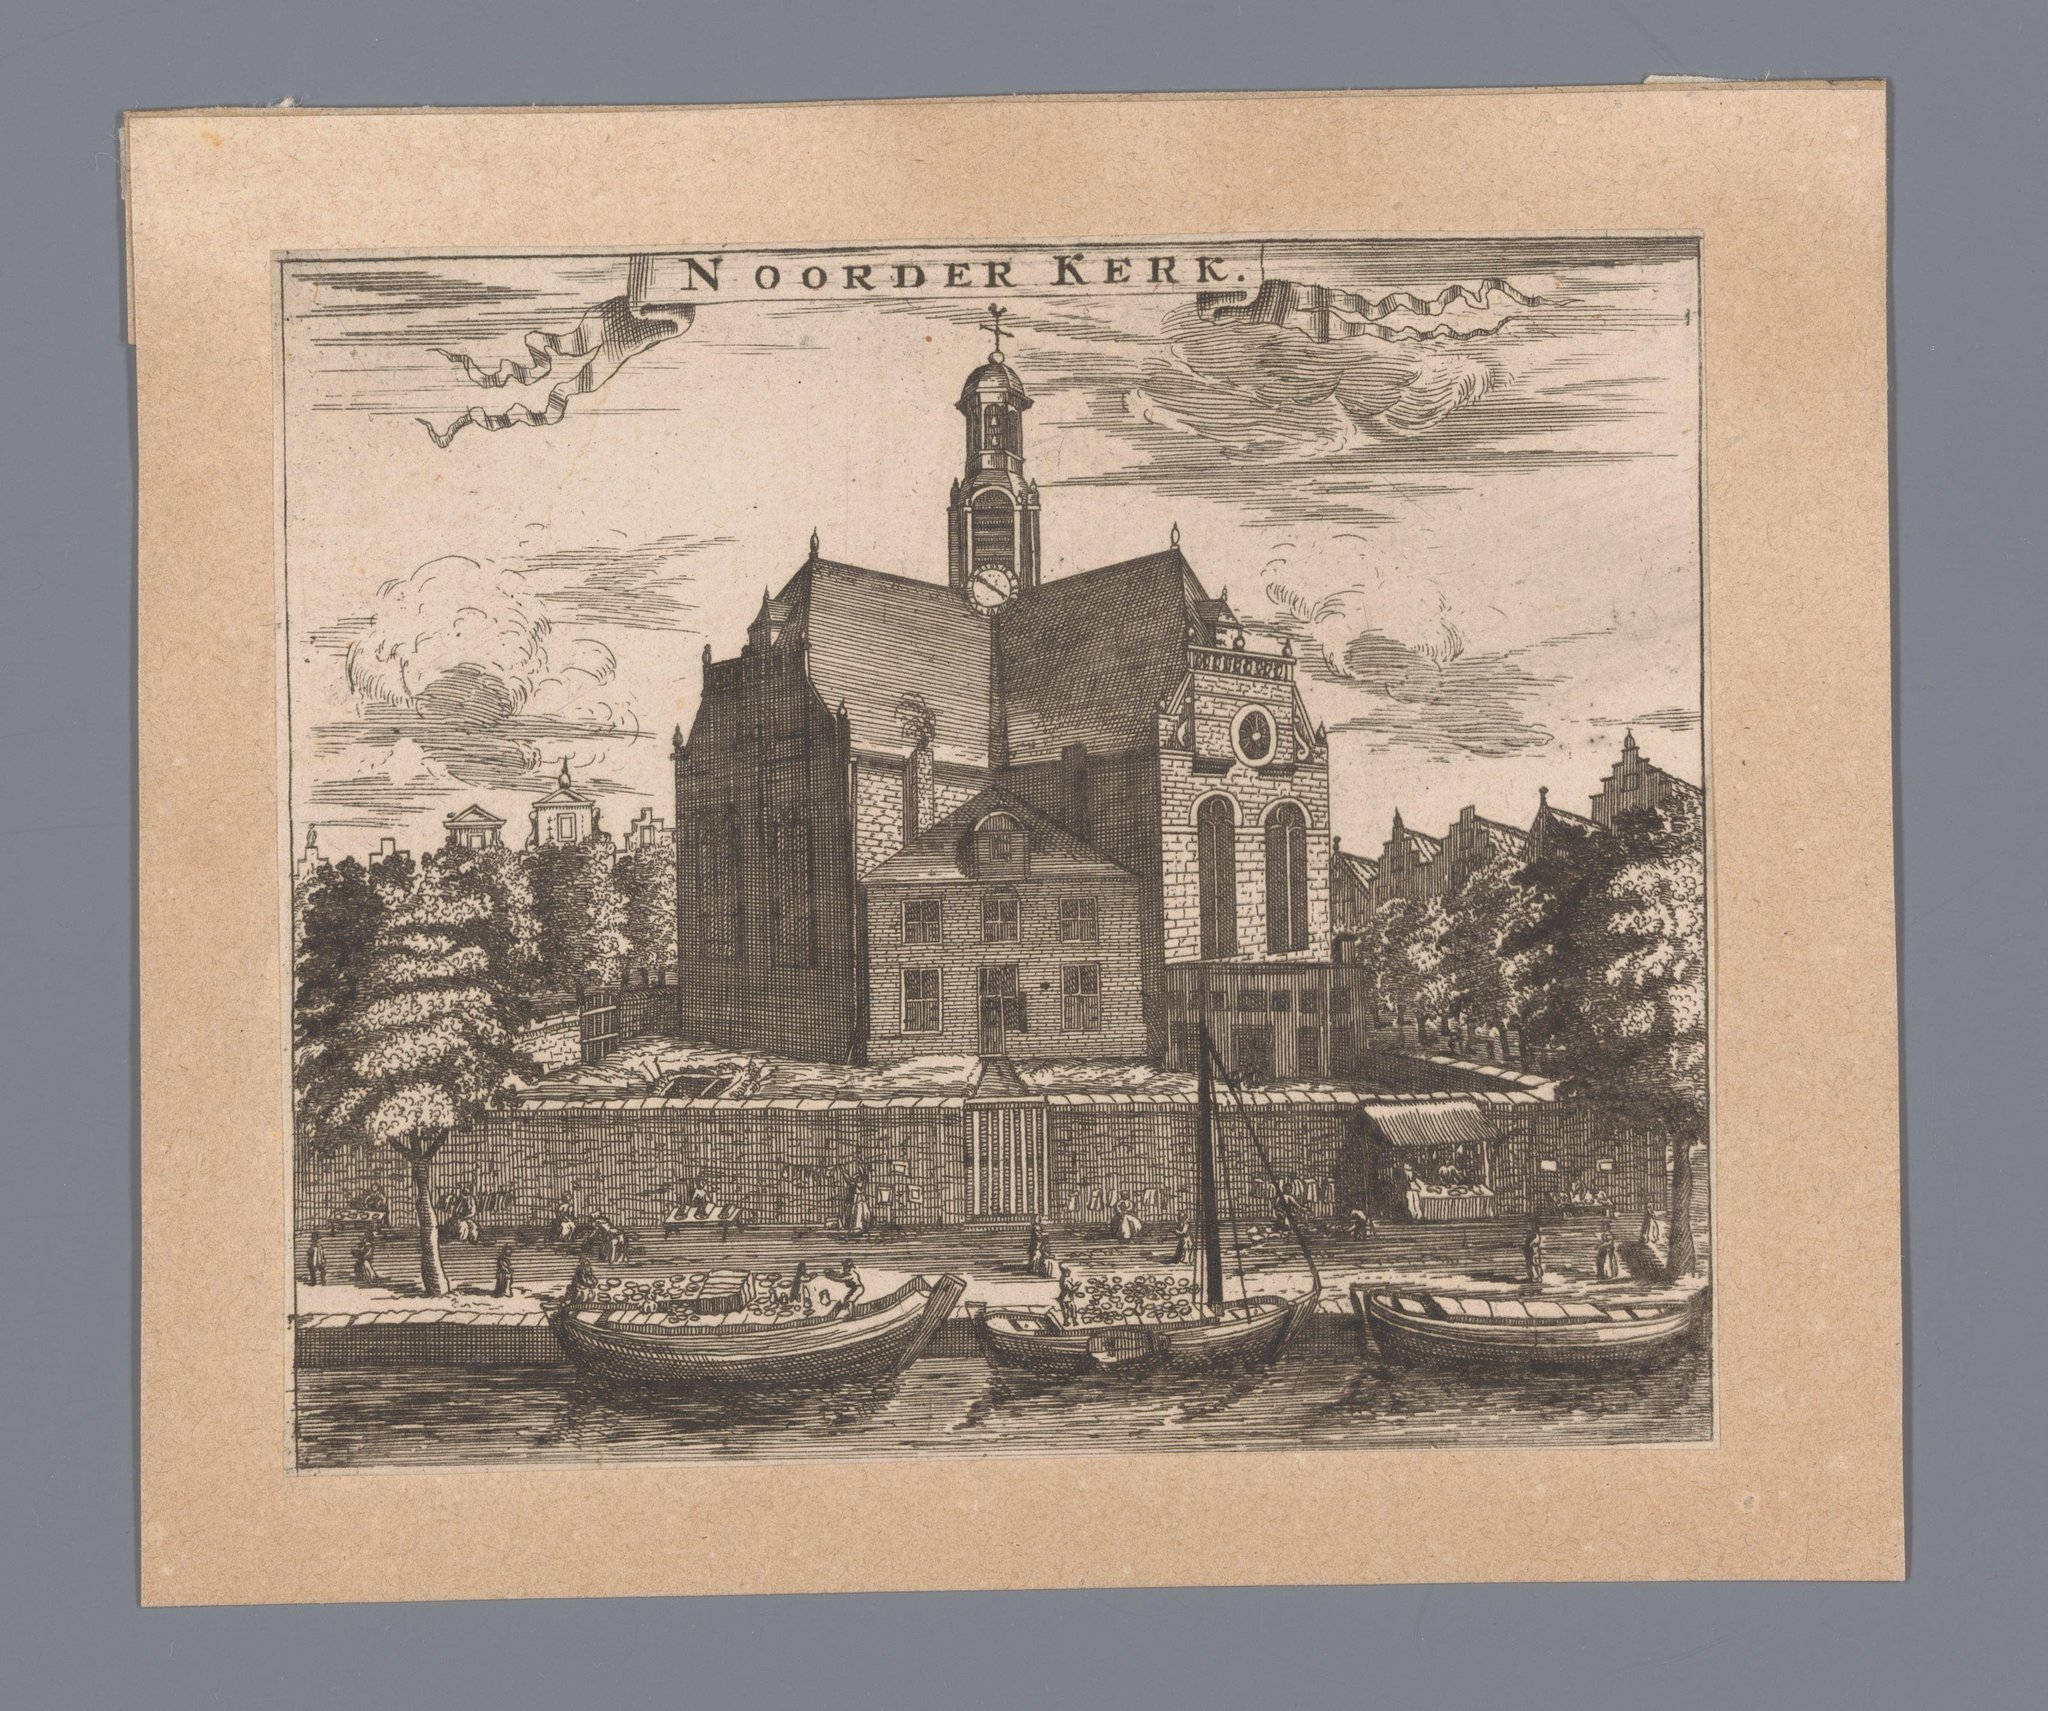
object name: print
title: Gezicht op de Noorderkerk te Amsterdam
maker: Anonymous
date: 1680-1730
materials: paper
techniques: etching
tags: church (exterior), market